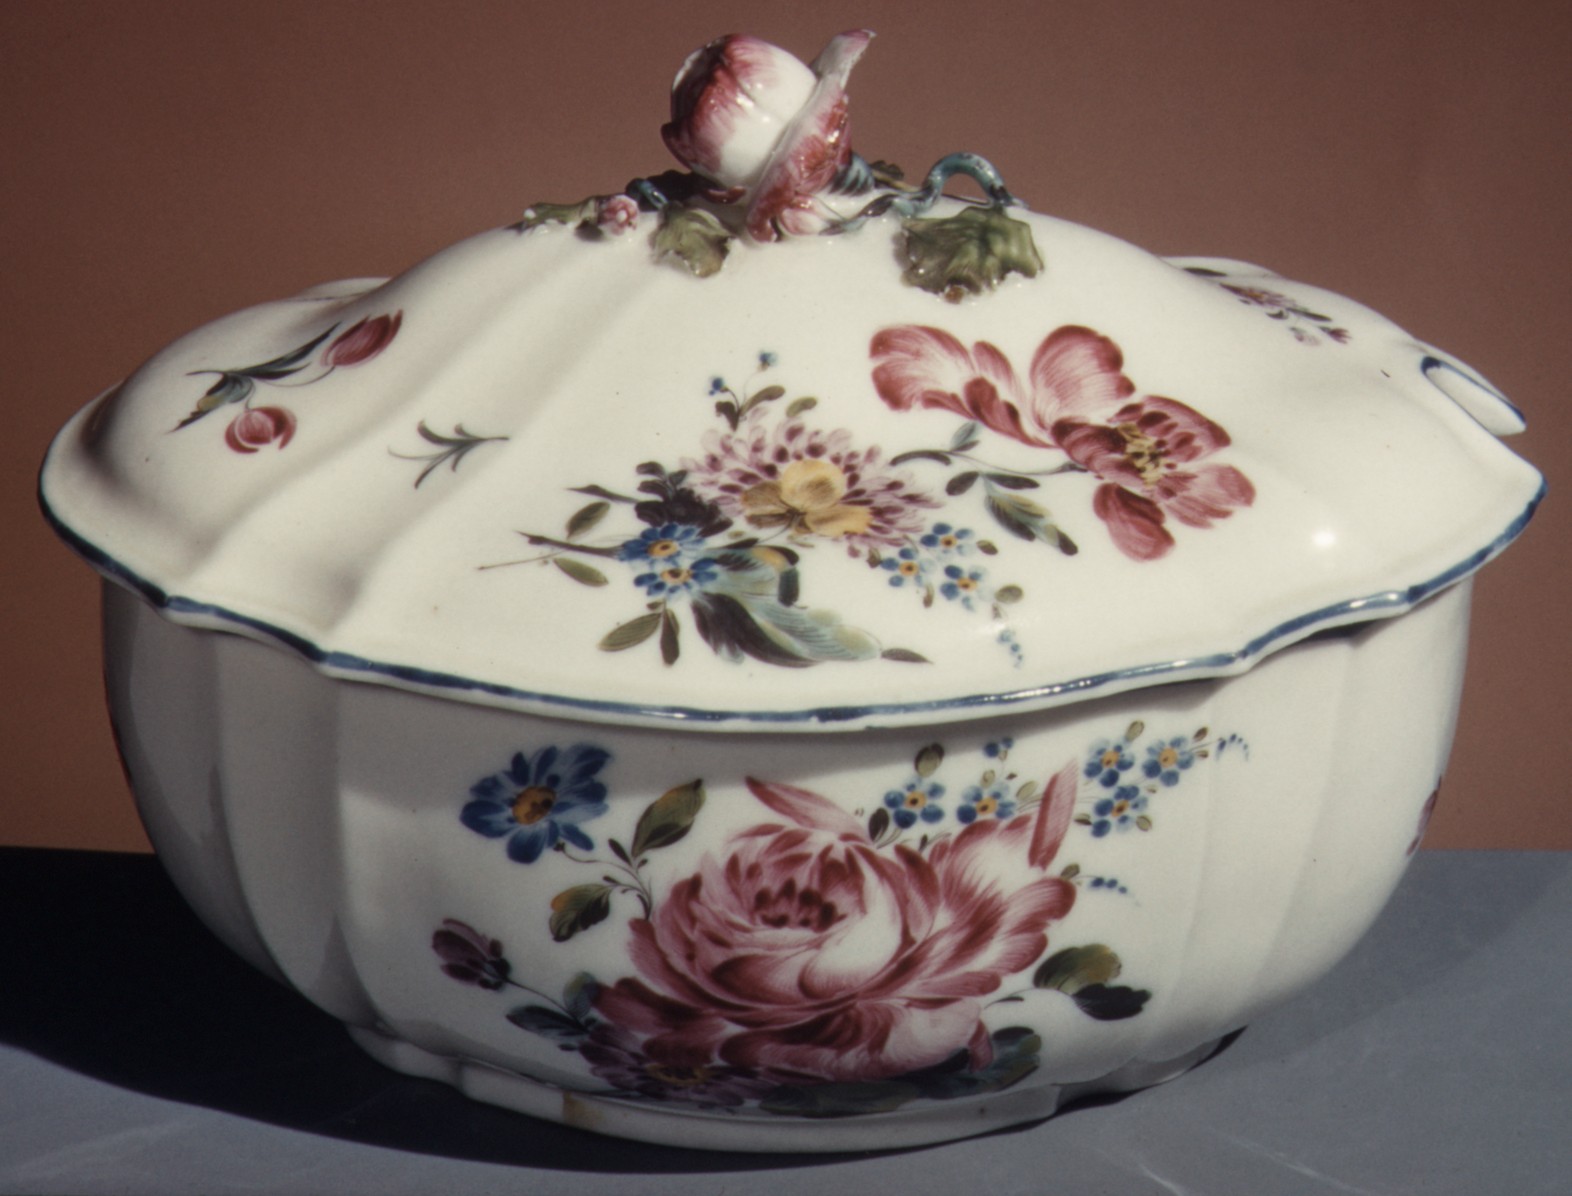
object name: sugar bowl with cover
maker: mennecy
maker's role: factory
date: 1760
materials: soft paste porcelain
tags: flowers